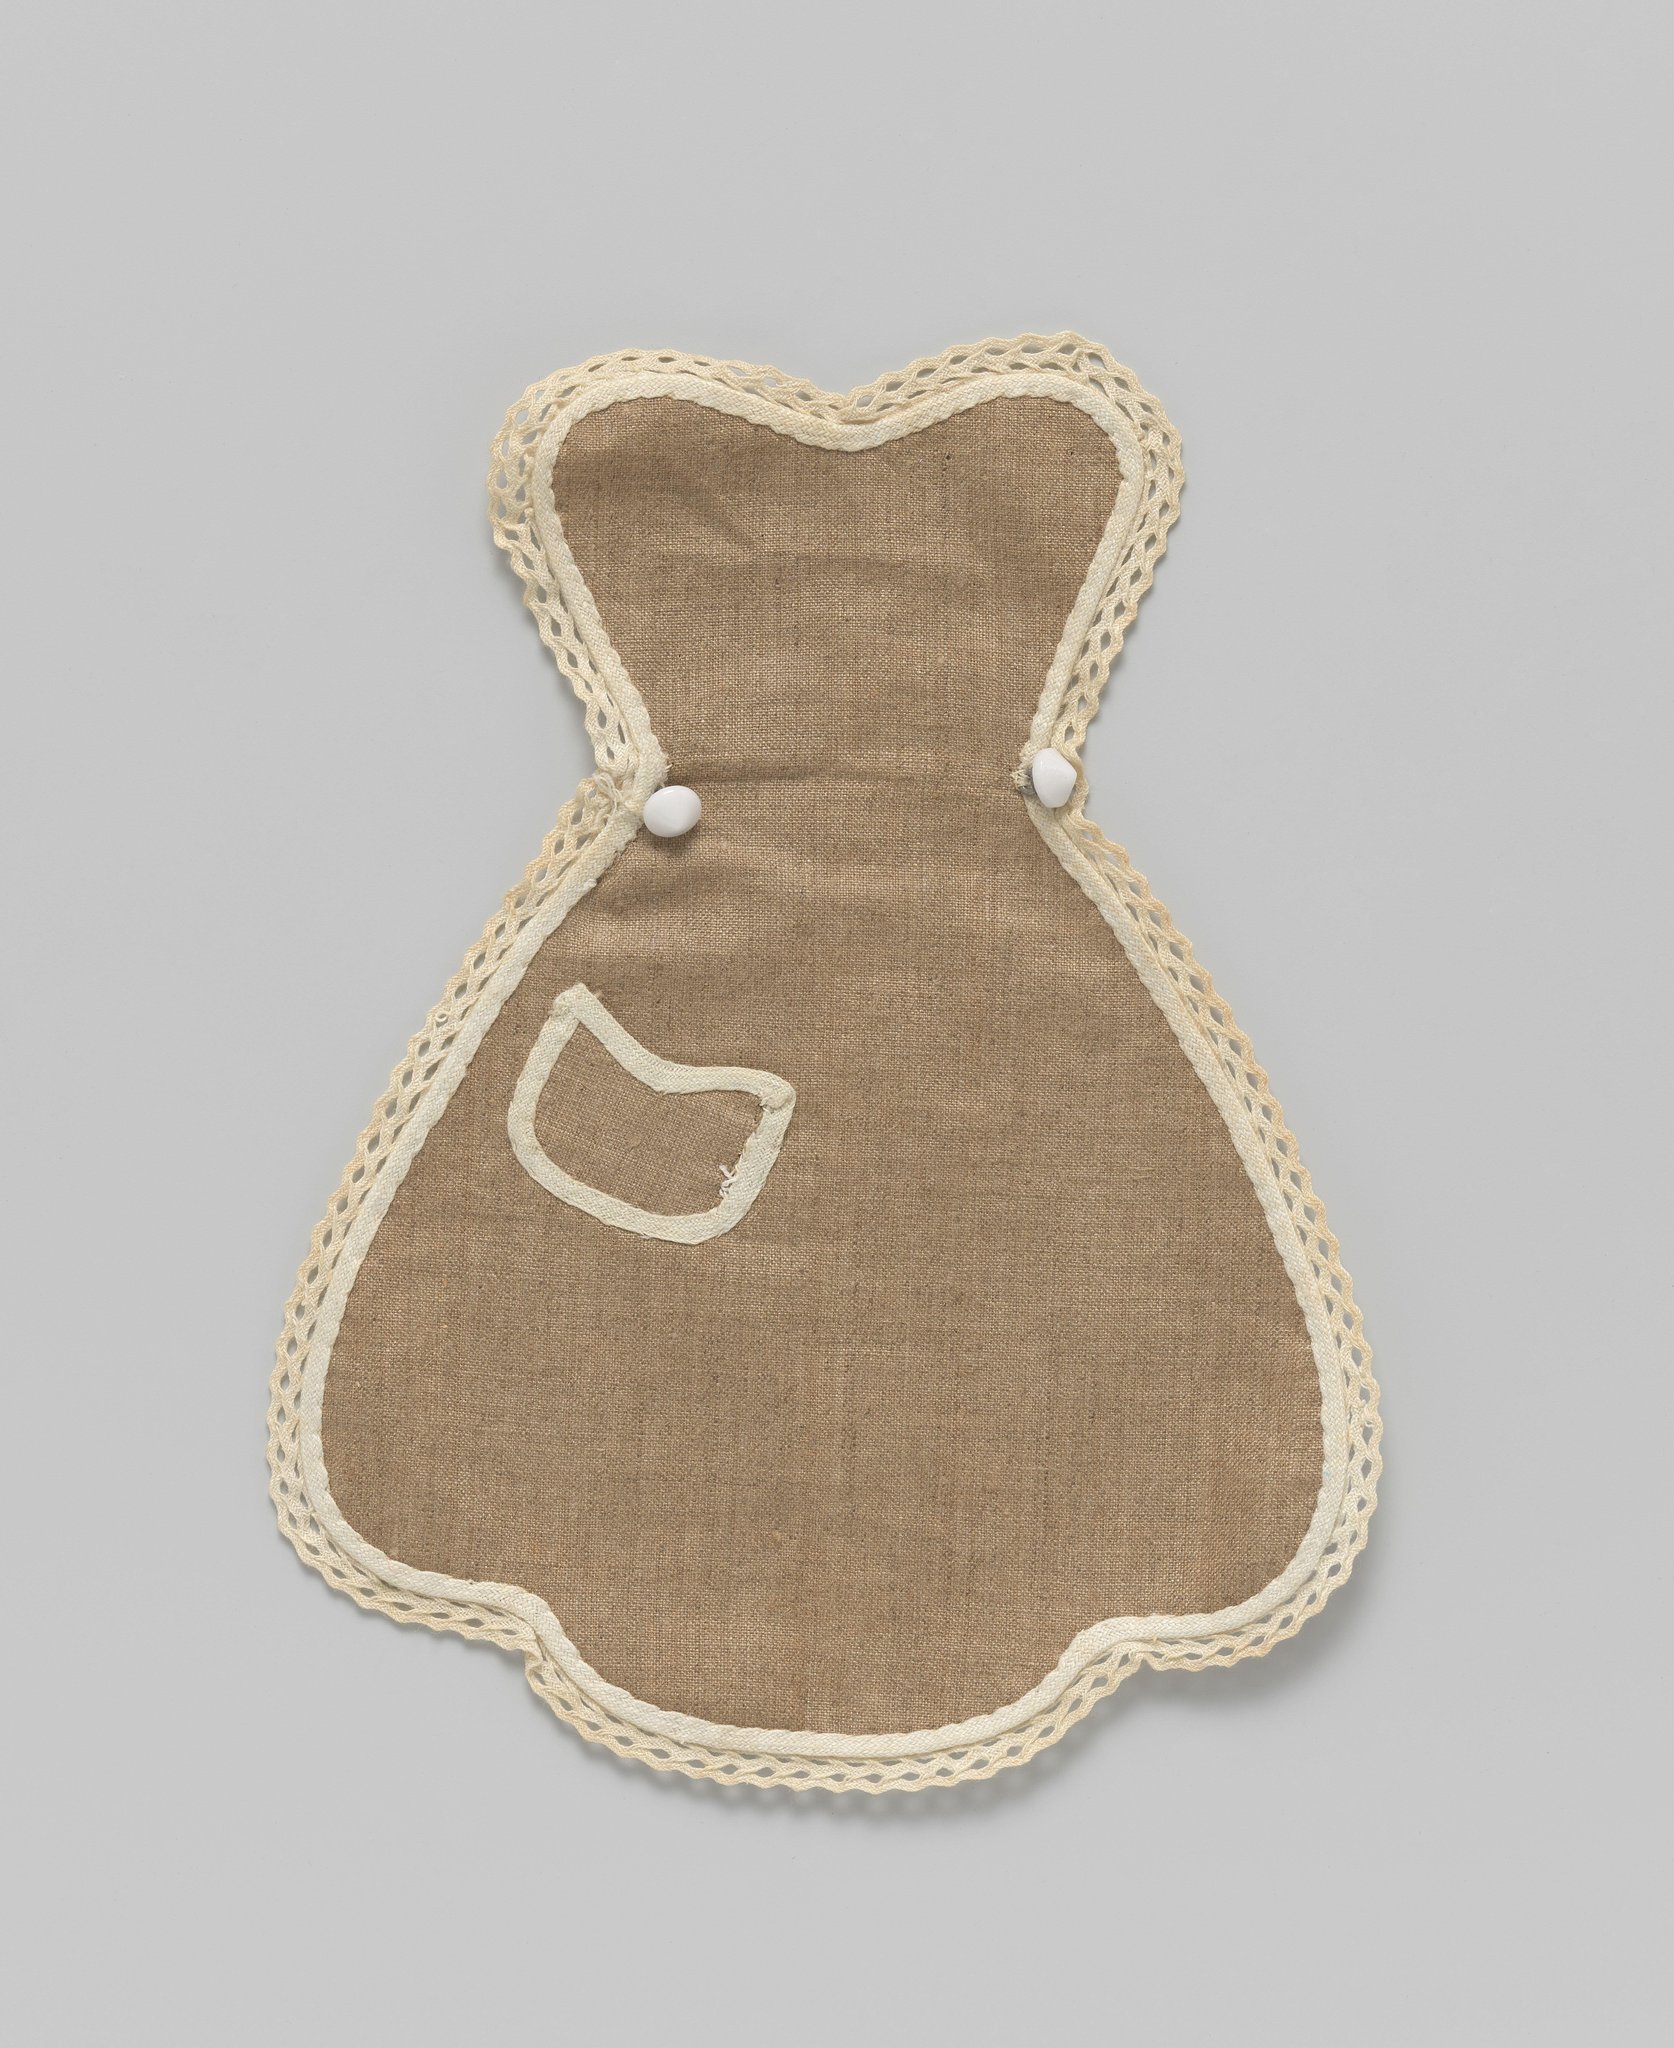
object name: doll's clothing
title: Schort van bruin linnen afgezet met rand wit kant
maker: Anonymous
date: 1850-1920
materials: linen, plastic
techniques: sewing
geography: europe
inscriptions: number: ‘RBK15445’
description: In de taille zit aan weerszijden een konisch knoopje van wit kunststof. Er is een zak opgenaaid.